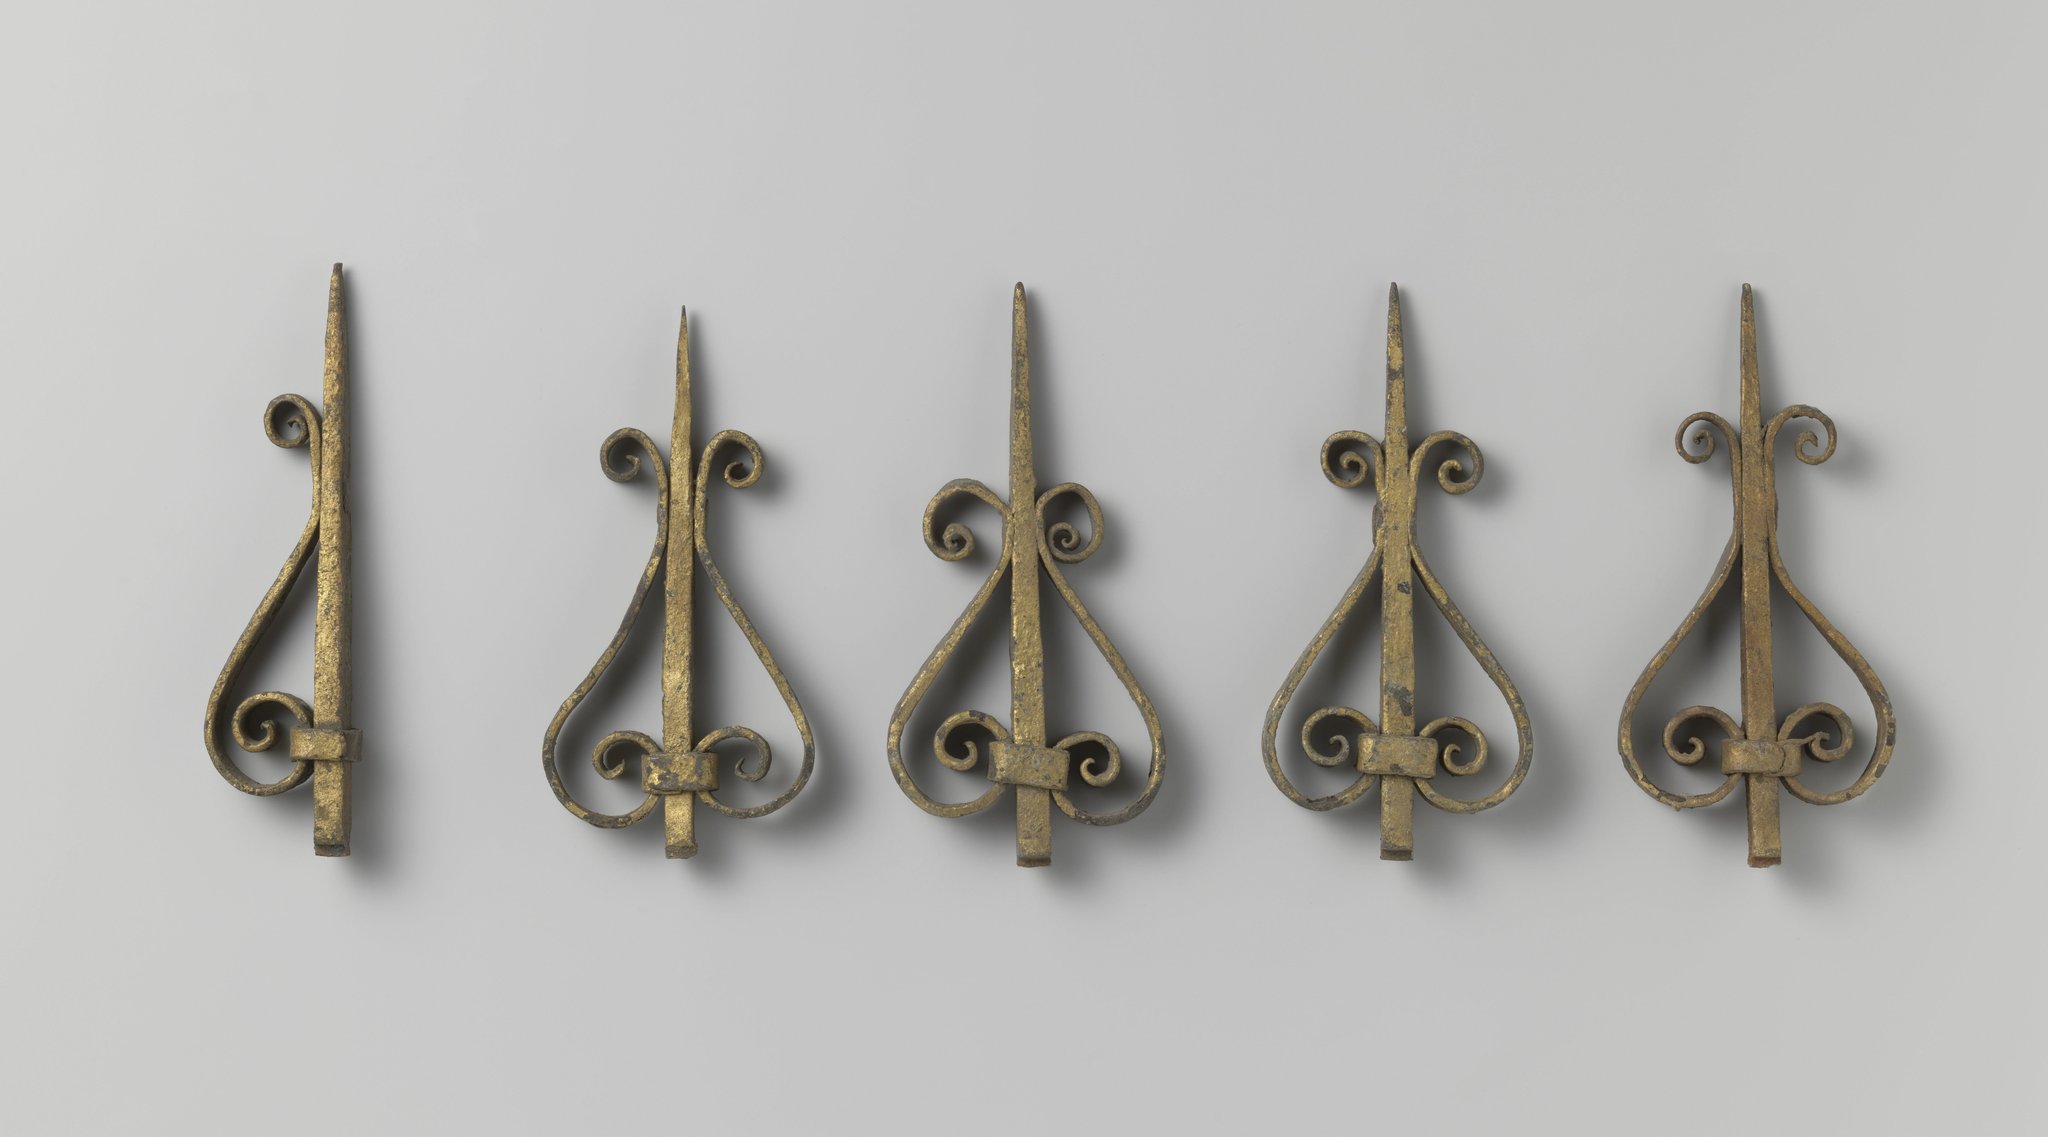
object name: hekdeur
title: Vijf afgebroken ornamenten van hekdeur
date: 1600-1625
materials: copper, iron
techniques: gilding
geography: italy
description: Een hek bestaande uit twee deuren en twee zijpanelen. Onderaan vertonen zij een plint versierd met een dubbele rij van hartvormig samengestelde S-voluten en enige rozetten. Door de plint steken de spijlen die het middenvak vullen en een smal fries dragen, bezet met een rij geprofileerde bollen. Het fries wordt afwisselend bekroond door een lange, geprofileerde knop, op voetstuk en een korte, rechtop staande spits toelopende stang waartegen twee S-voluten zijn geplaatst. Ijzer ten dele verguld. Koper.